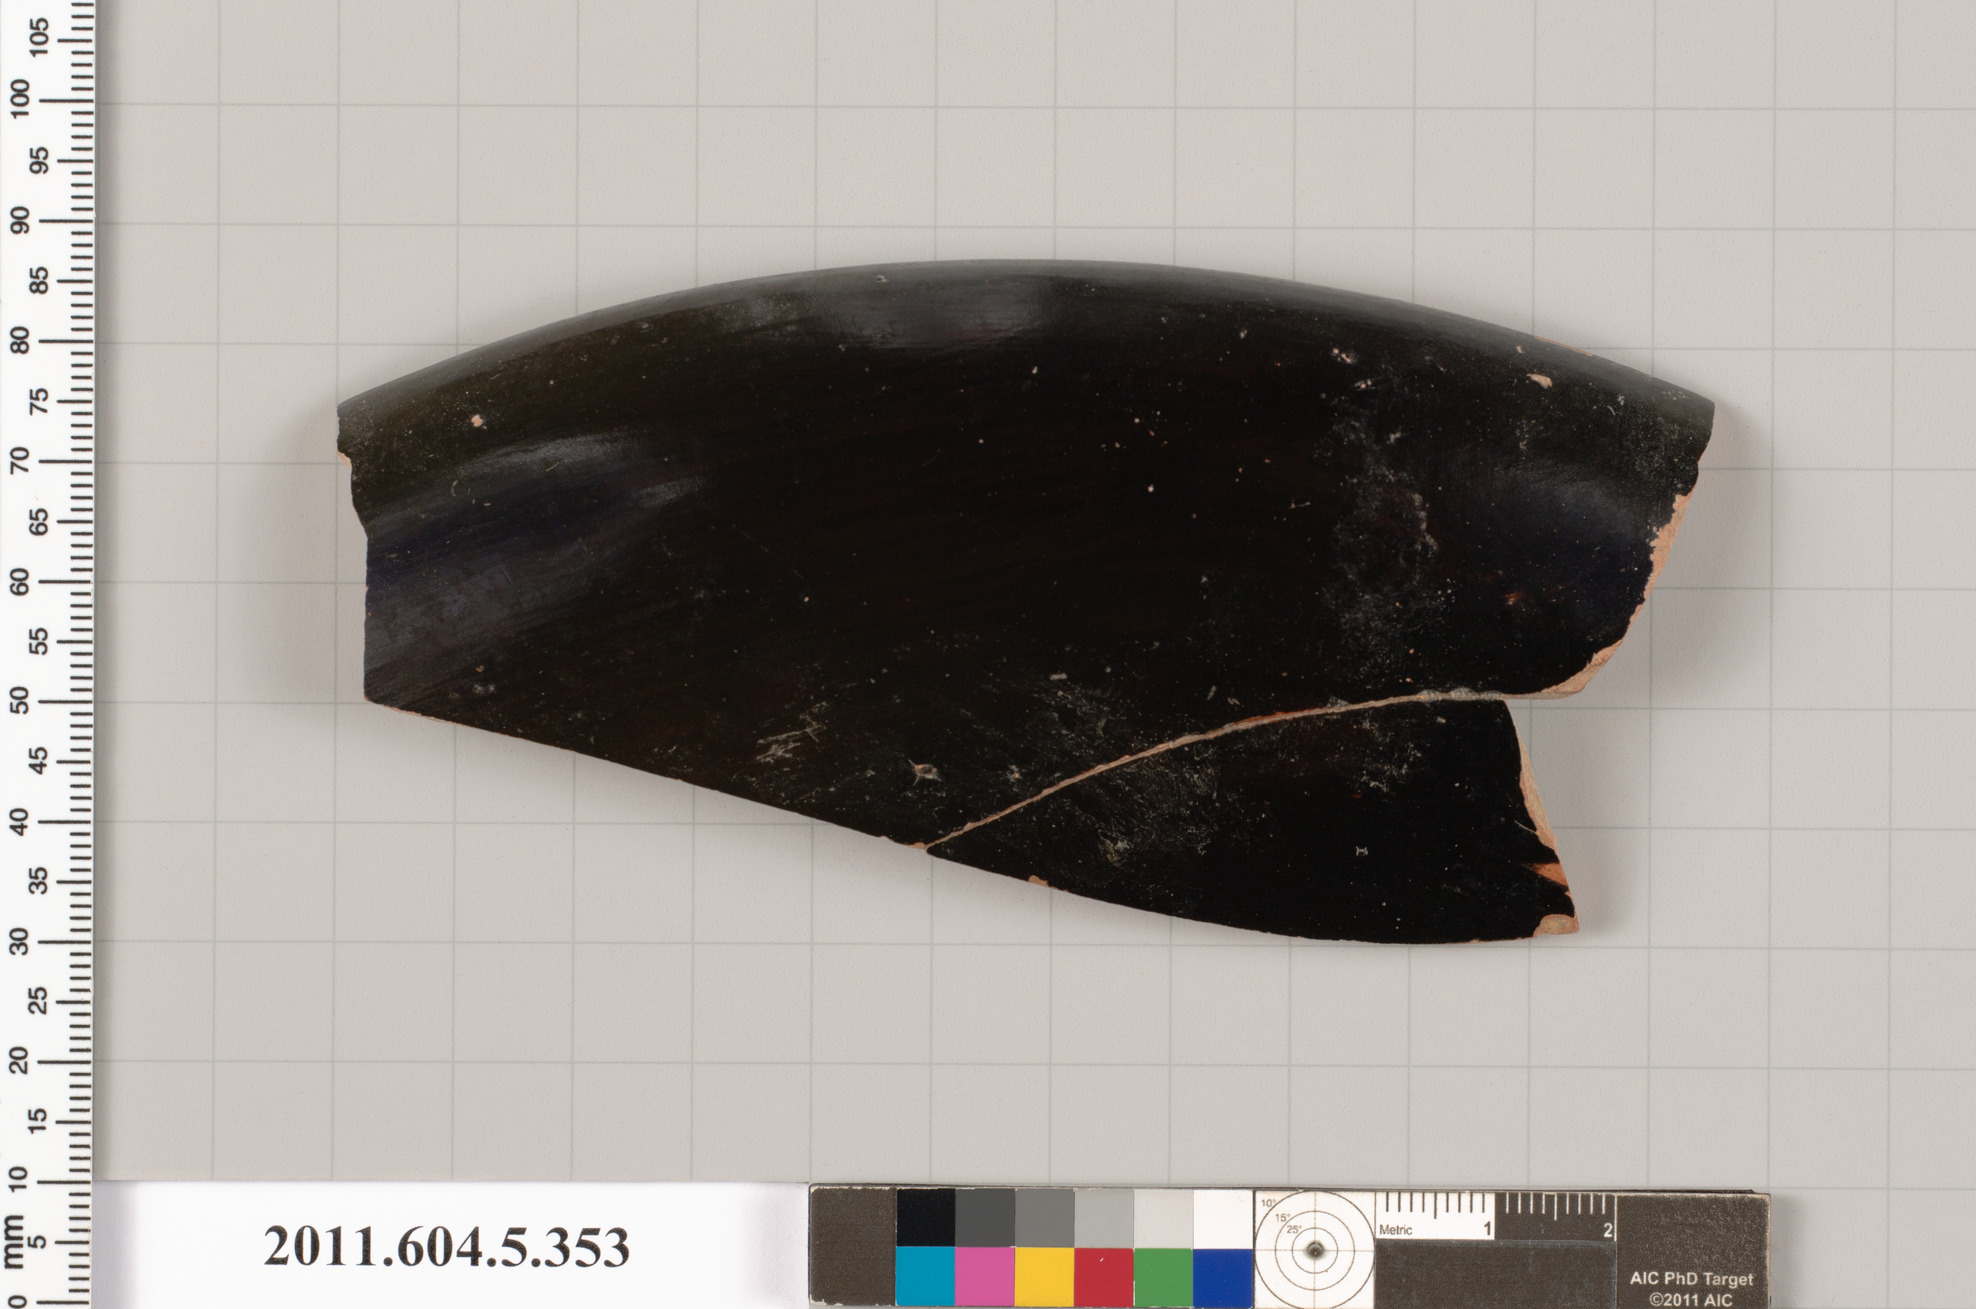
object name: kylix fragment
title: Terracotta rim fragment of a kylix (drinking cup)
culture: greek, attic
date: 600-401 BCE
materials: terracotta